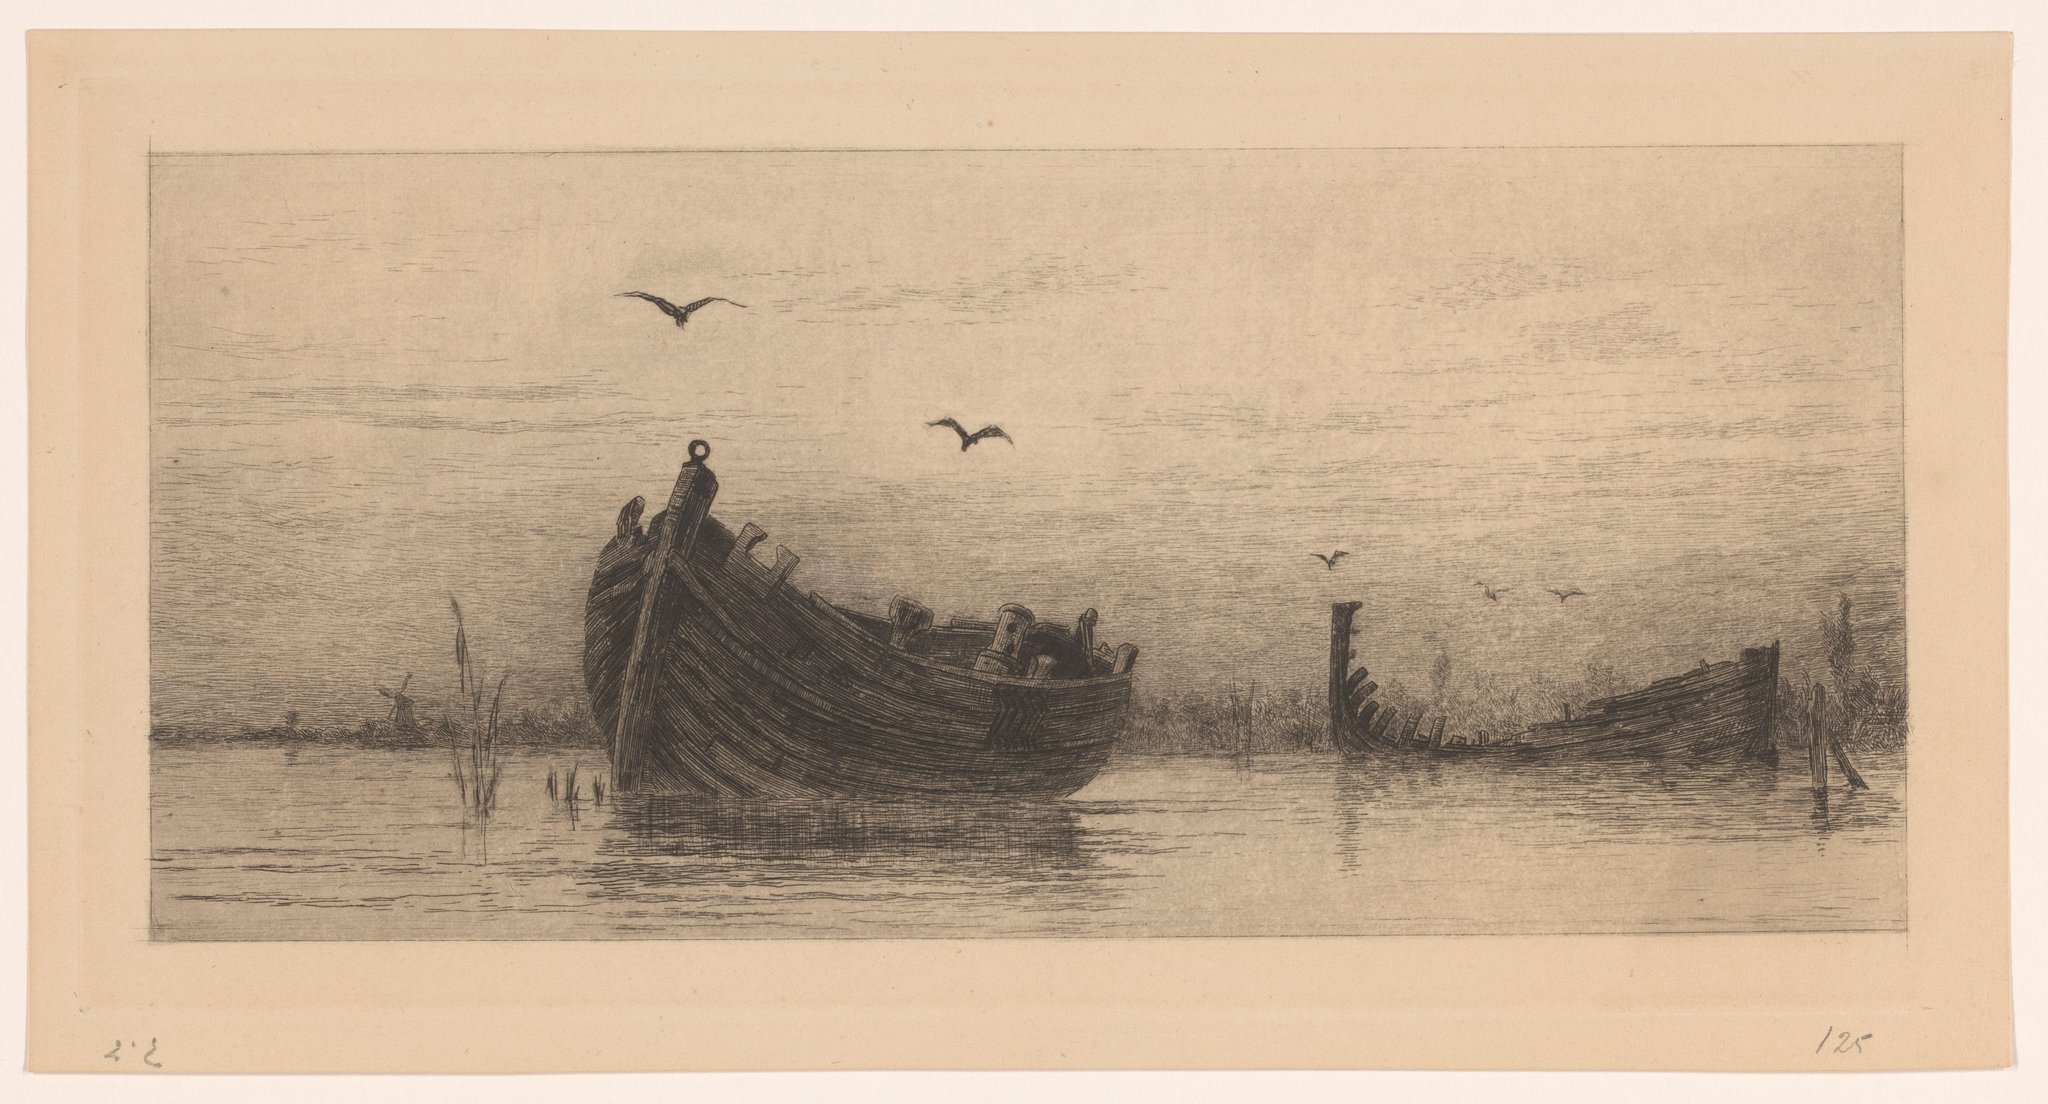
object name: print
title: Epaves dans le biesbosch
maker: carel nicolaas storm van s-gravesande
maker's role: draughtsman, print maker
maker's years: 1841-1924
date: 1880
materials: paper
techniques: etching, intaglio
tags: shipwreck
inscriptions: collector's mark: Lugt 2228